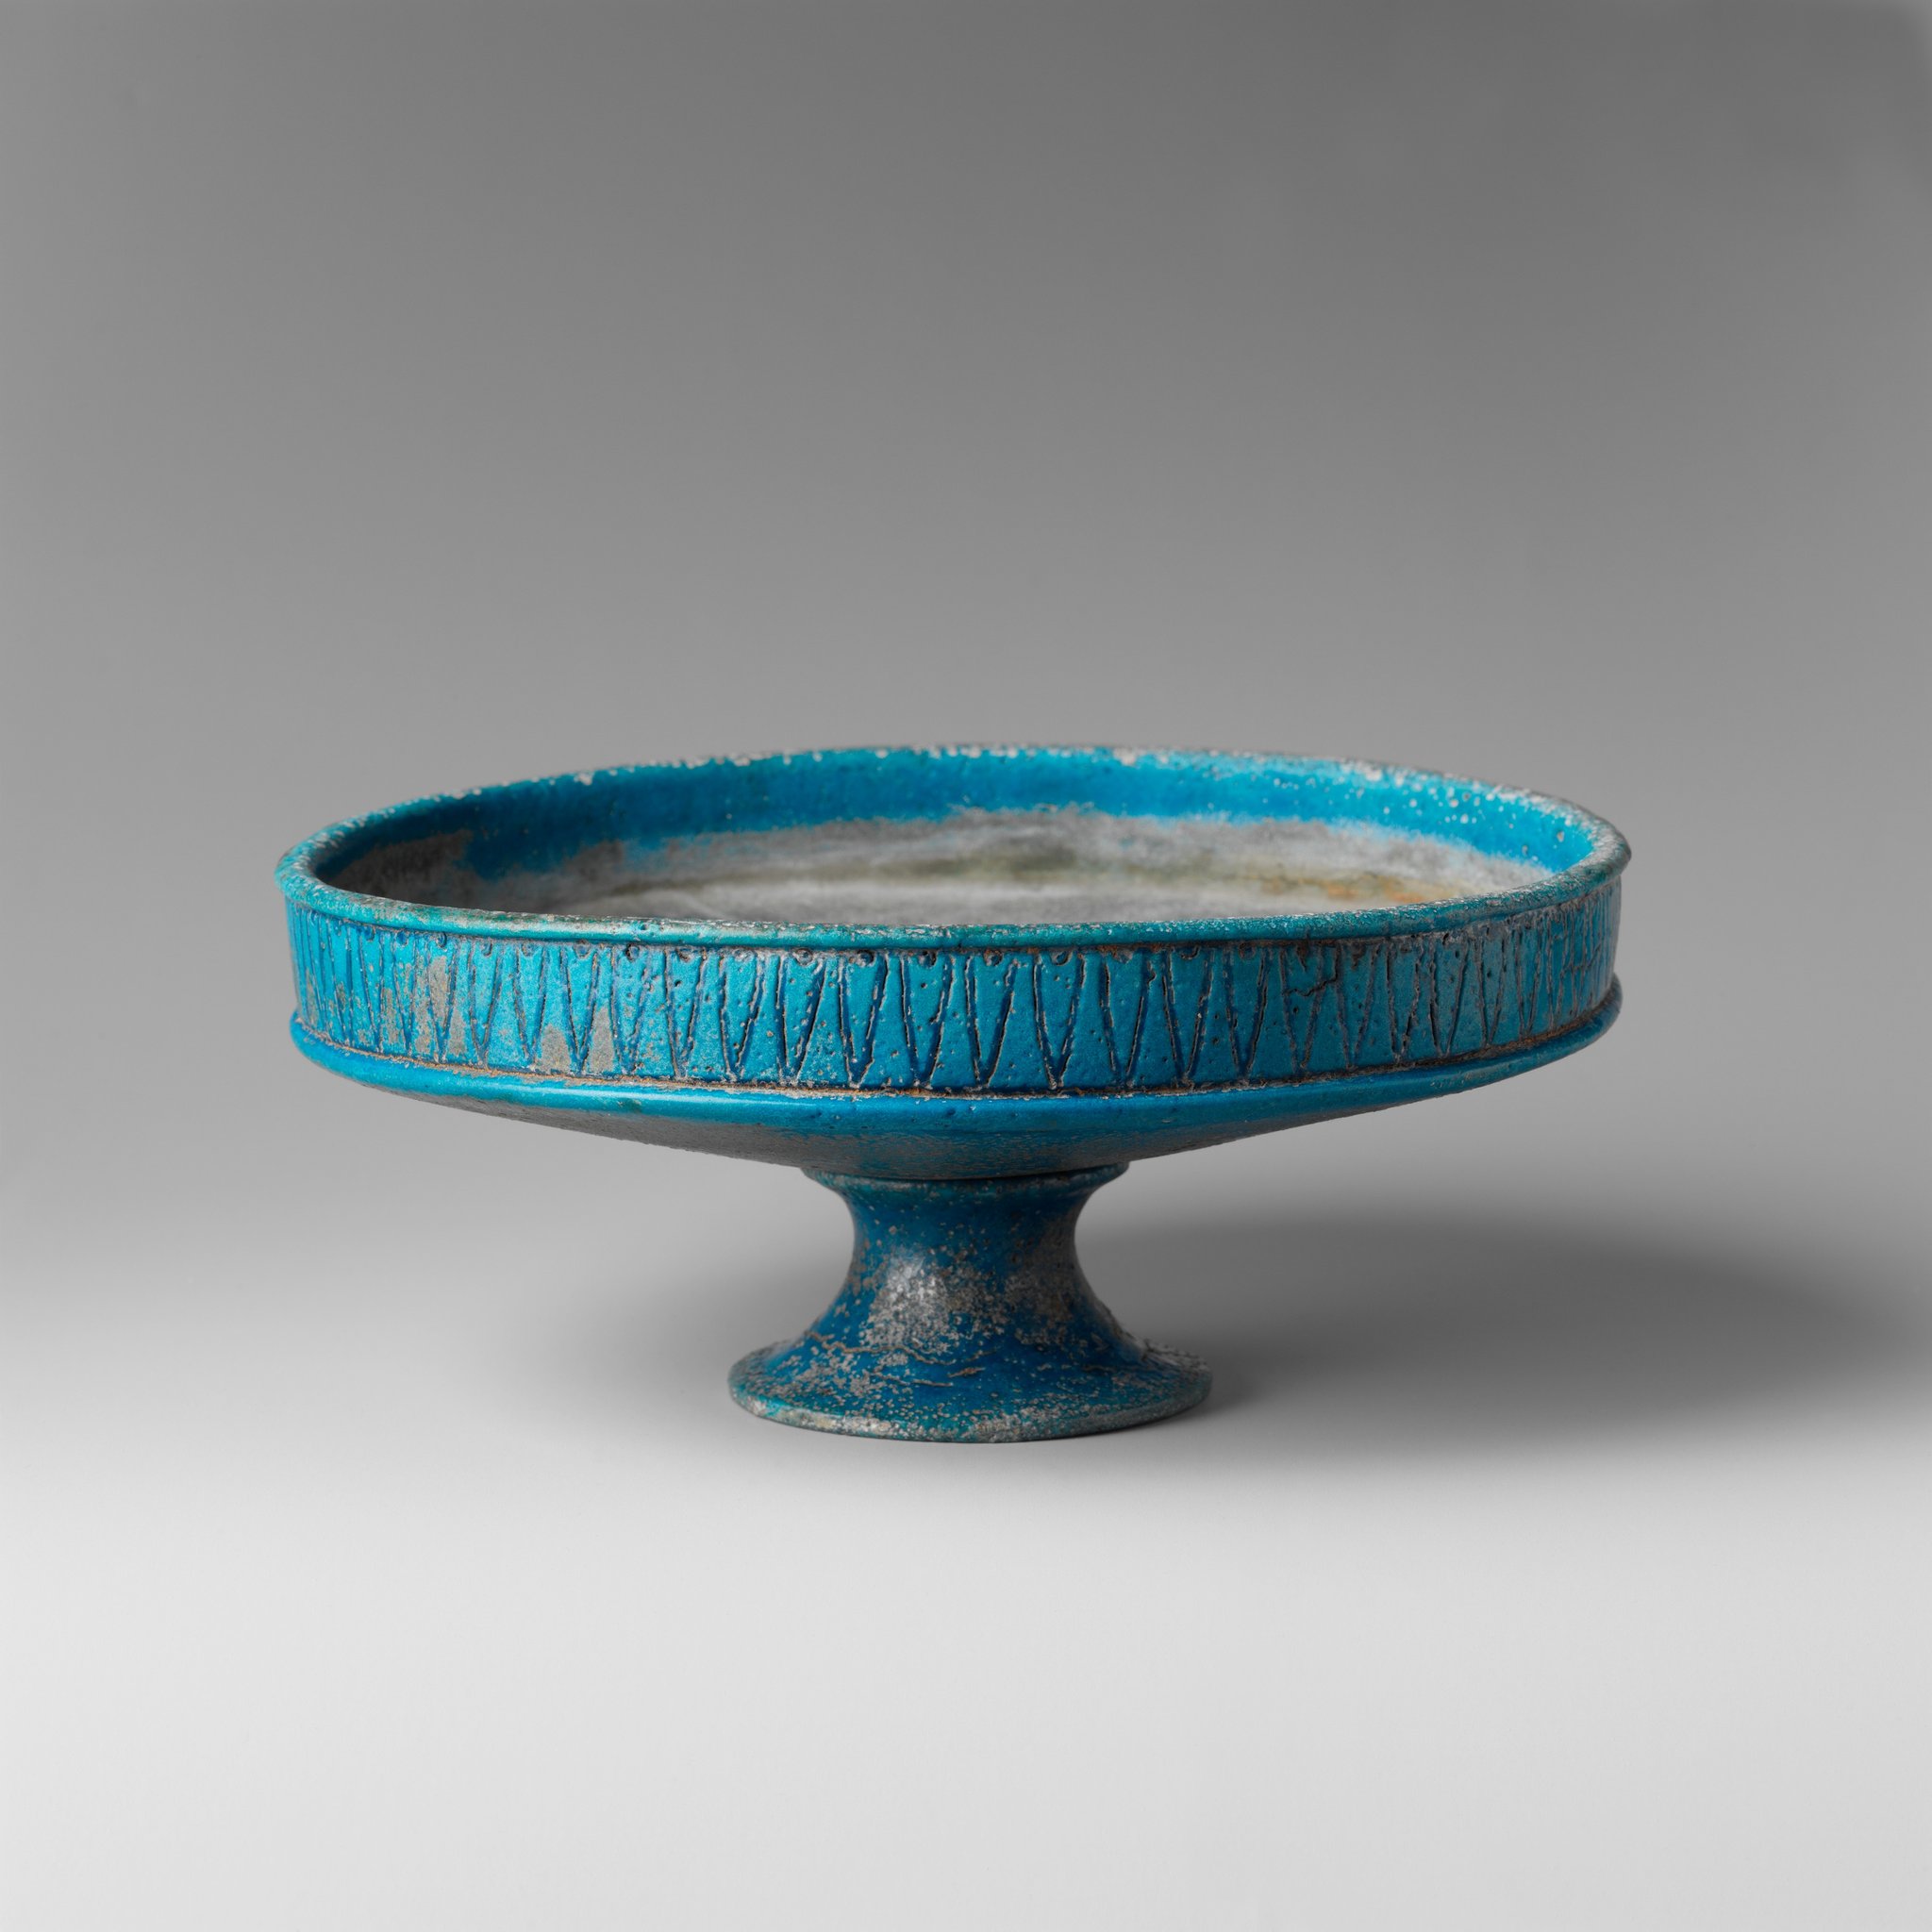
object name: cup, floral decoration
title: Cup on a Stand with Flower Décor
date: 1400-1352 BCE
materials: faience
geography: egypt